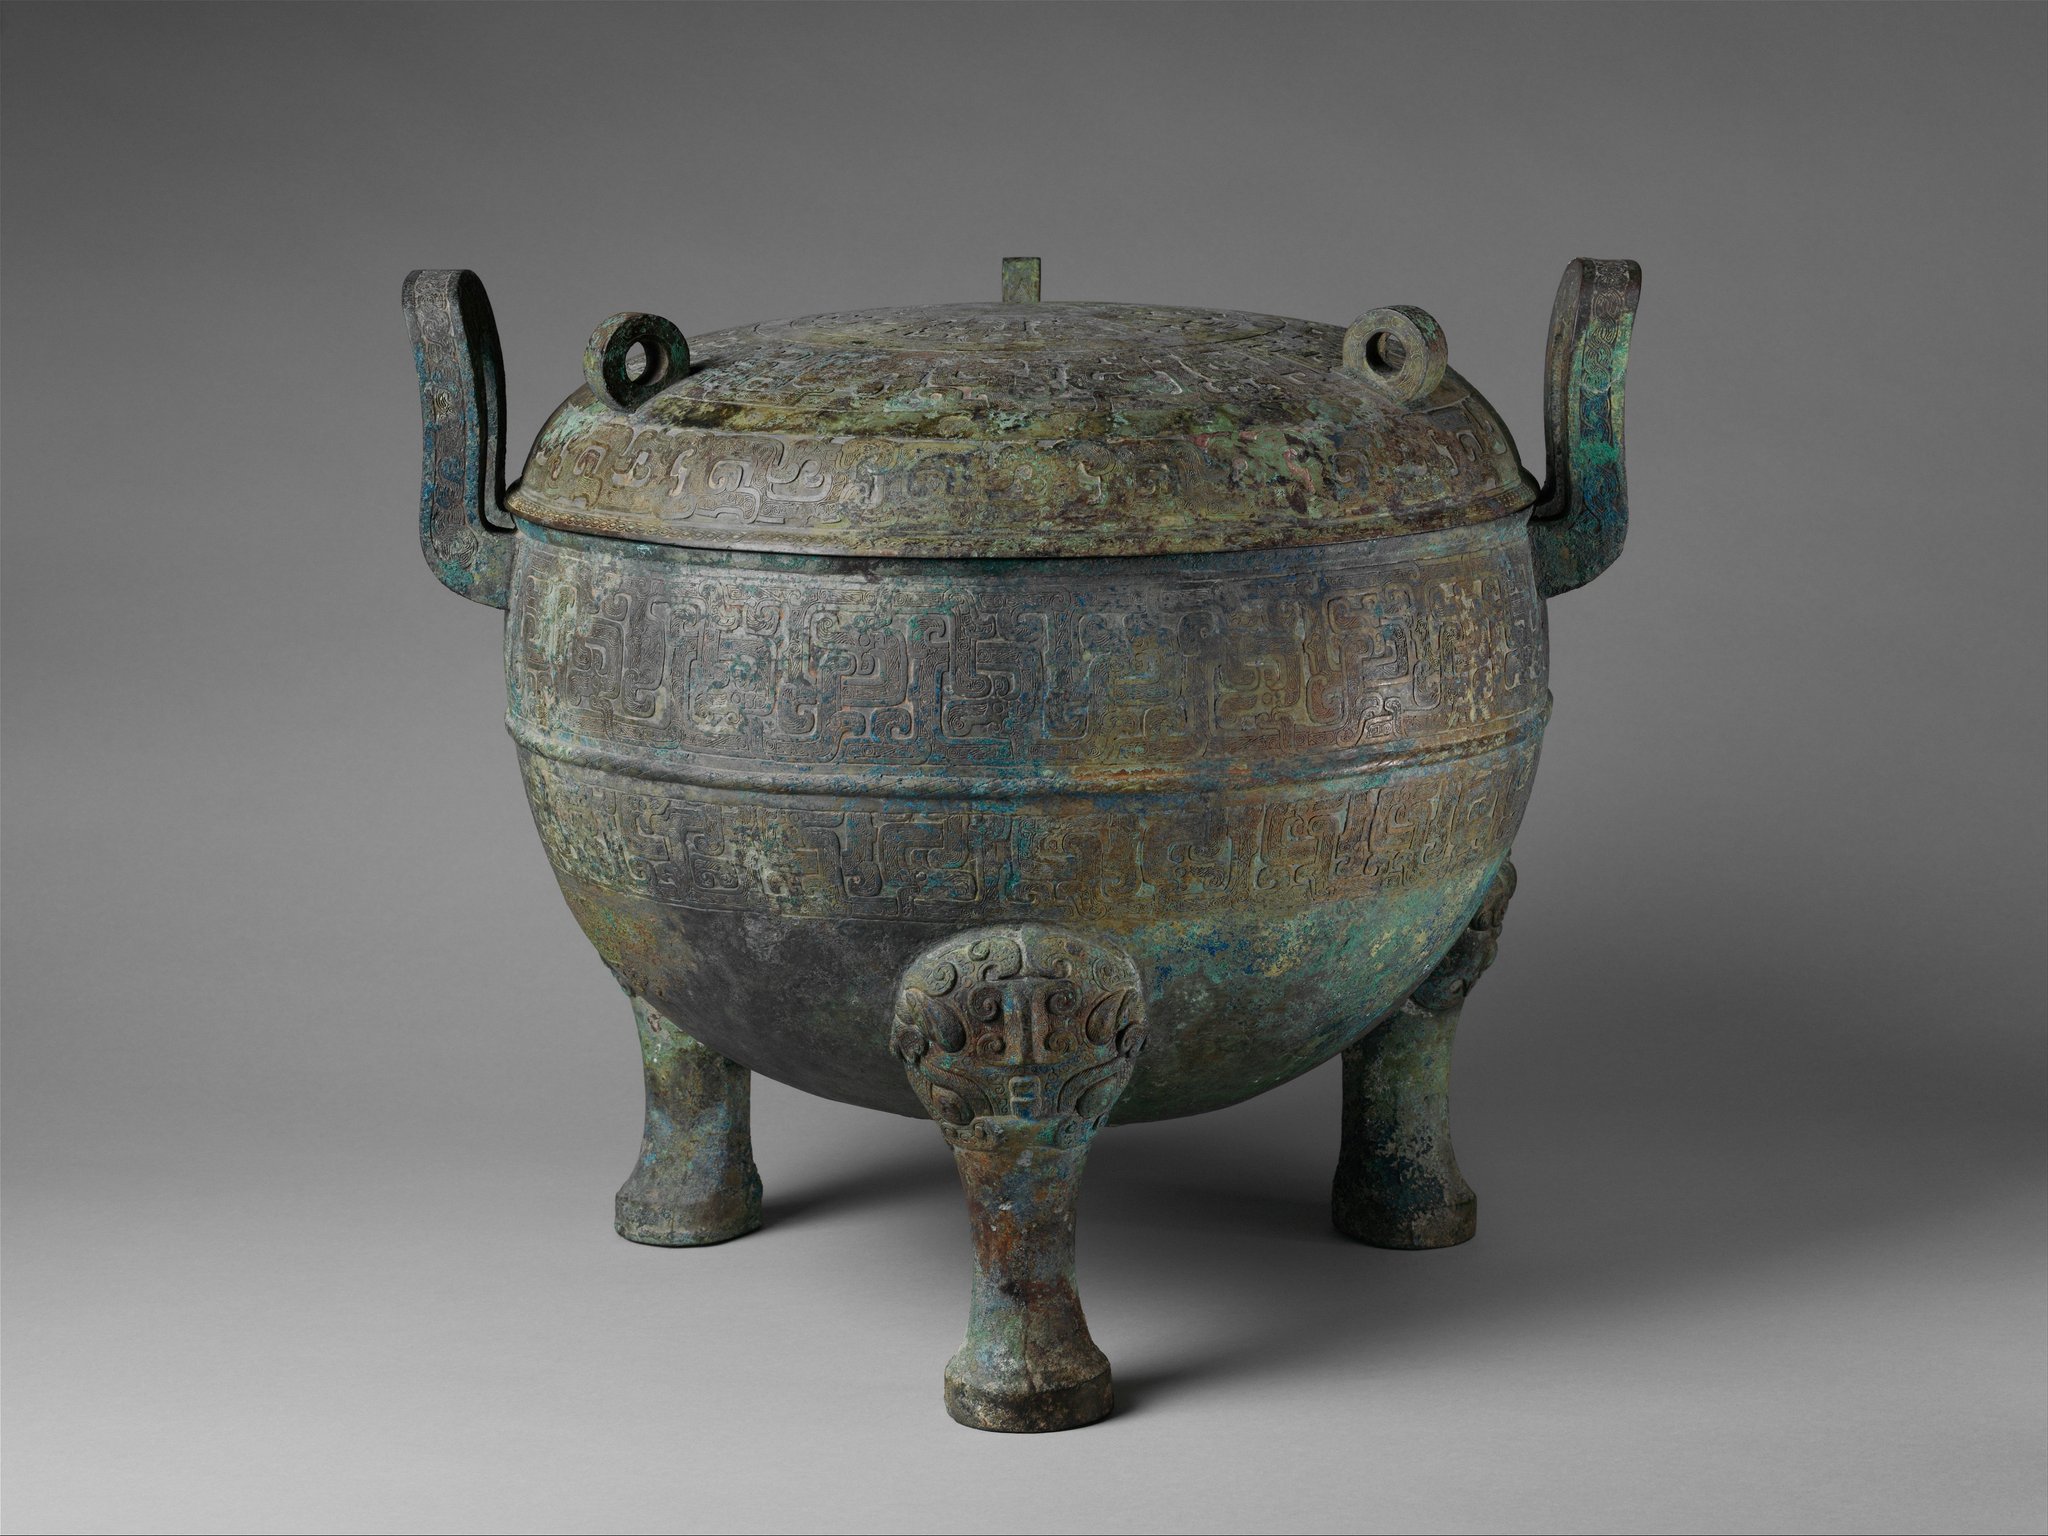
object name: cauldron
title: Ritual Tripod Cauldron with Cover (Ding)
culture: chinese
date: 500-301 BCE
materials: bronze